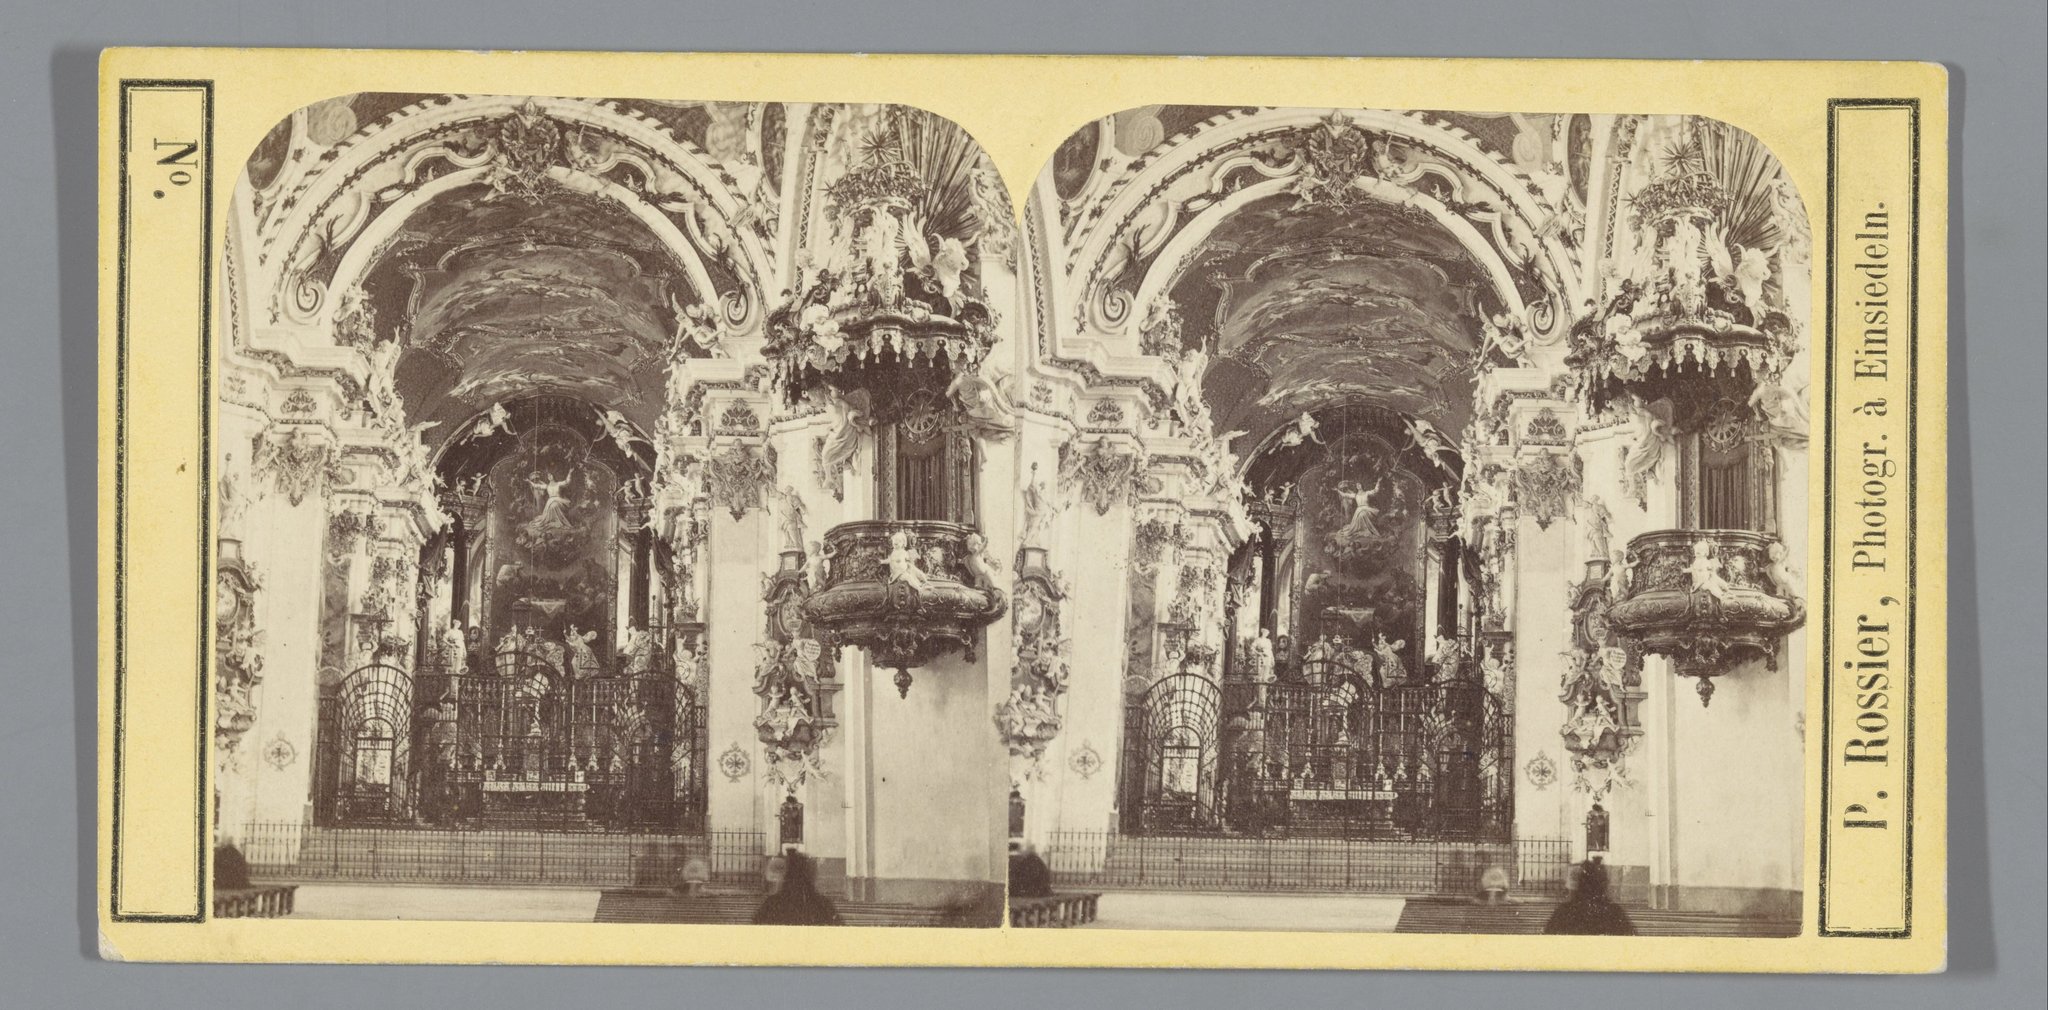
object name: stereograph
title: Kapel van de Heilige Maagd in de Abdij van Einsiedeln, Zwitserland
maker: pierre joseph rossier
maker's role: fotograaf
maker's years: 1829-1889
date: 1862-1870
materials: cardboard, paper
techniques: albumen print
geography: einsiedeln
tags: parts of church interior: chapel